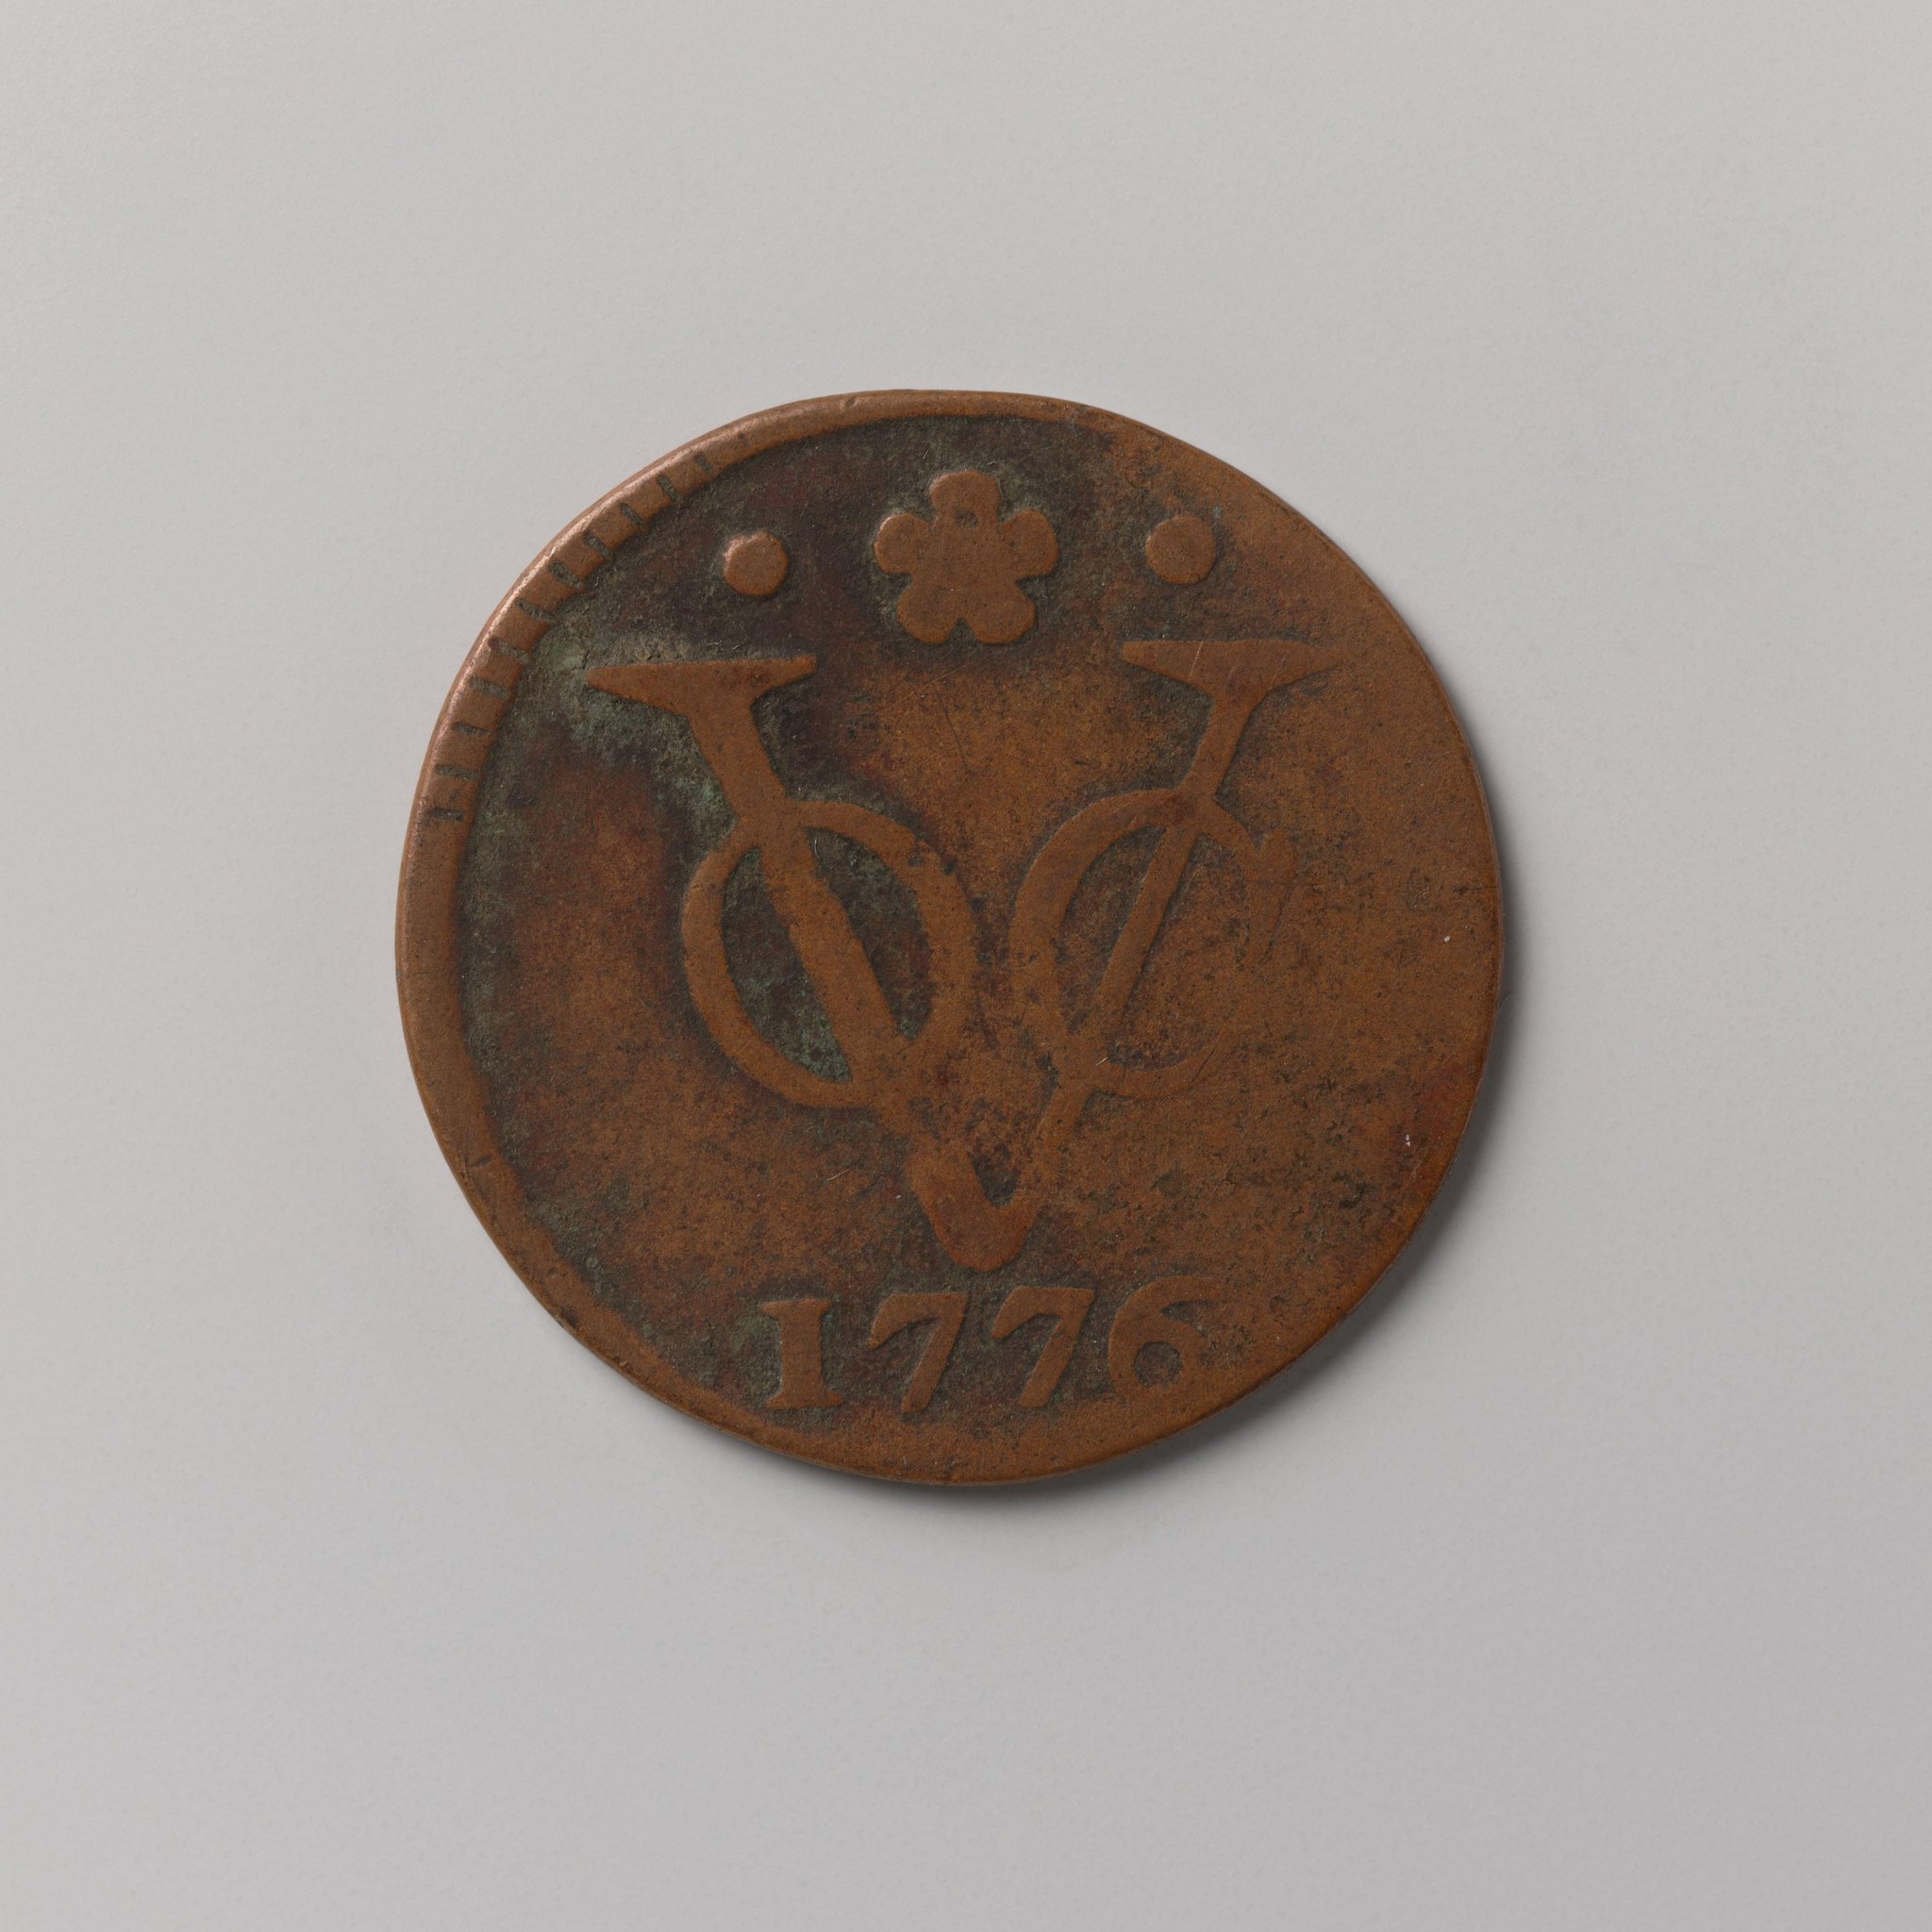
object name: coin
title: Duit van de VOC uit Holland, 1776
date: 1776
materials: copper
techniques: striking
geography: dordrecht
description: Koperen munt. Voorzijde: gekroond wapenschild van Holland. Keerzijde: monogram van de VOC, waarboven muntteken en waaronder jaartal. Gladde rand.